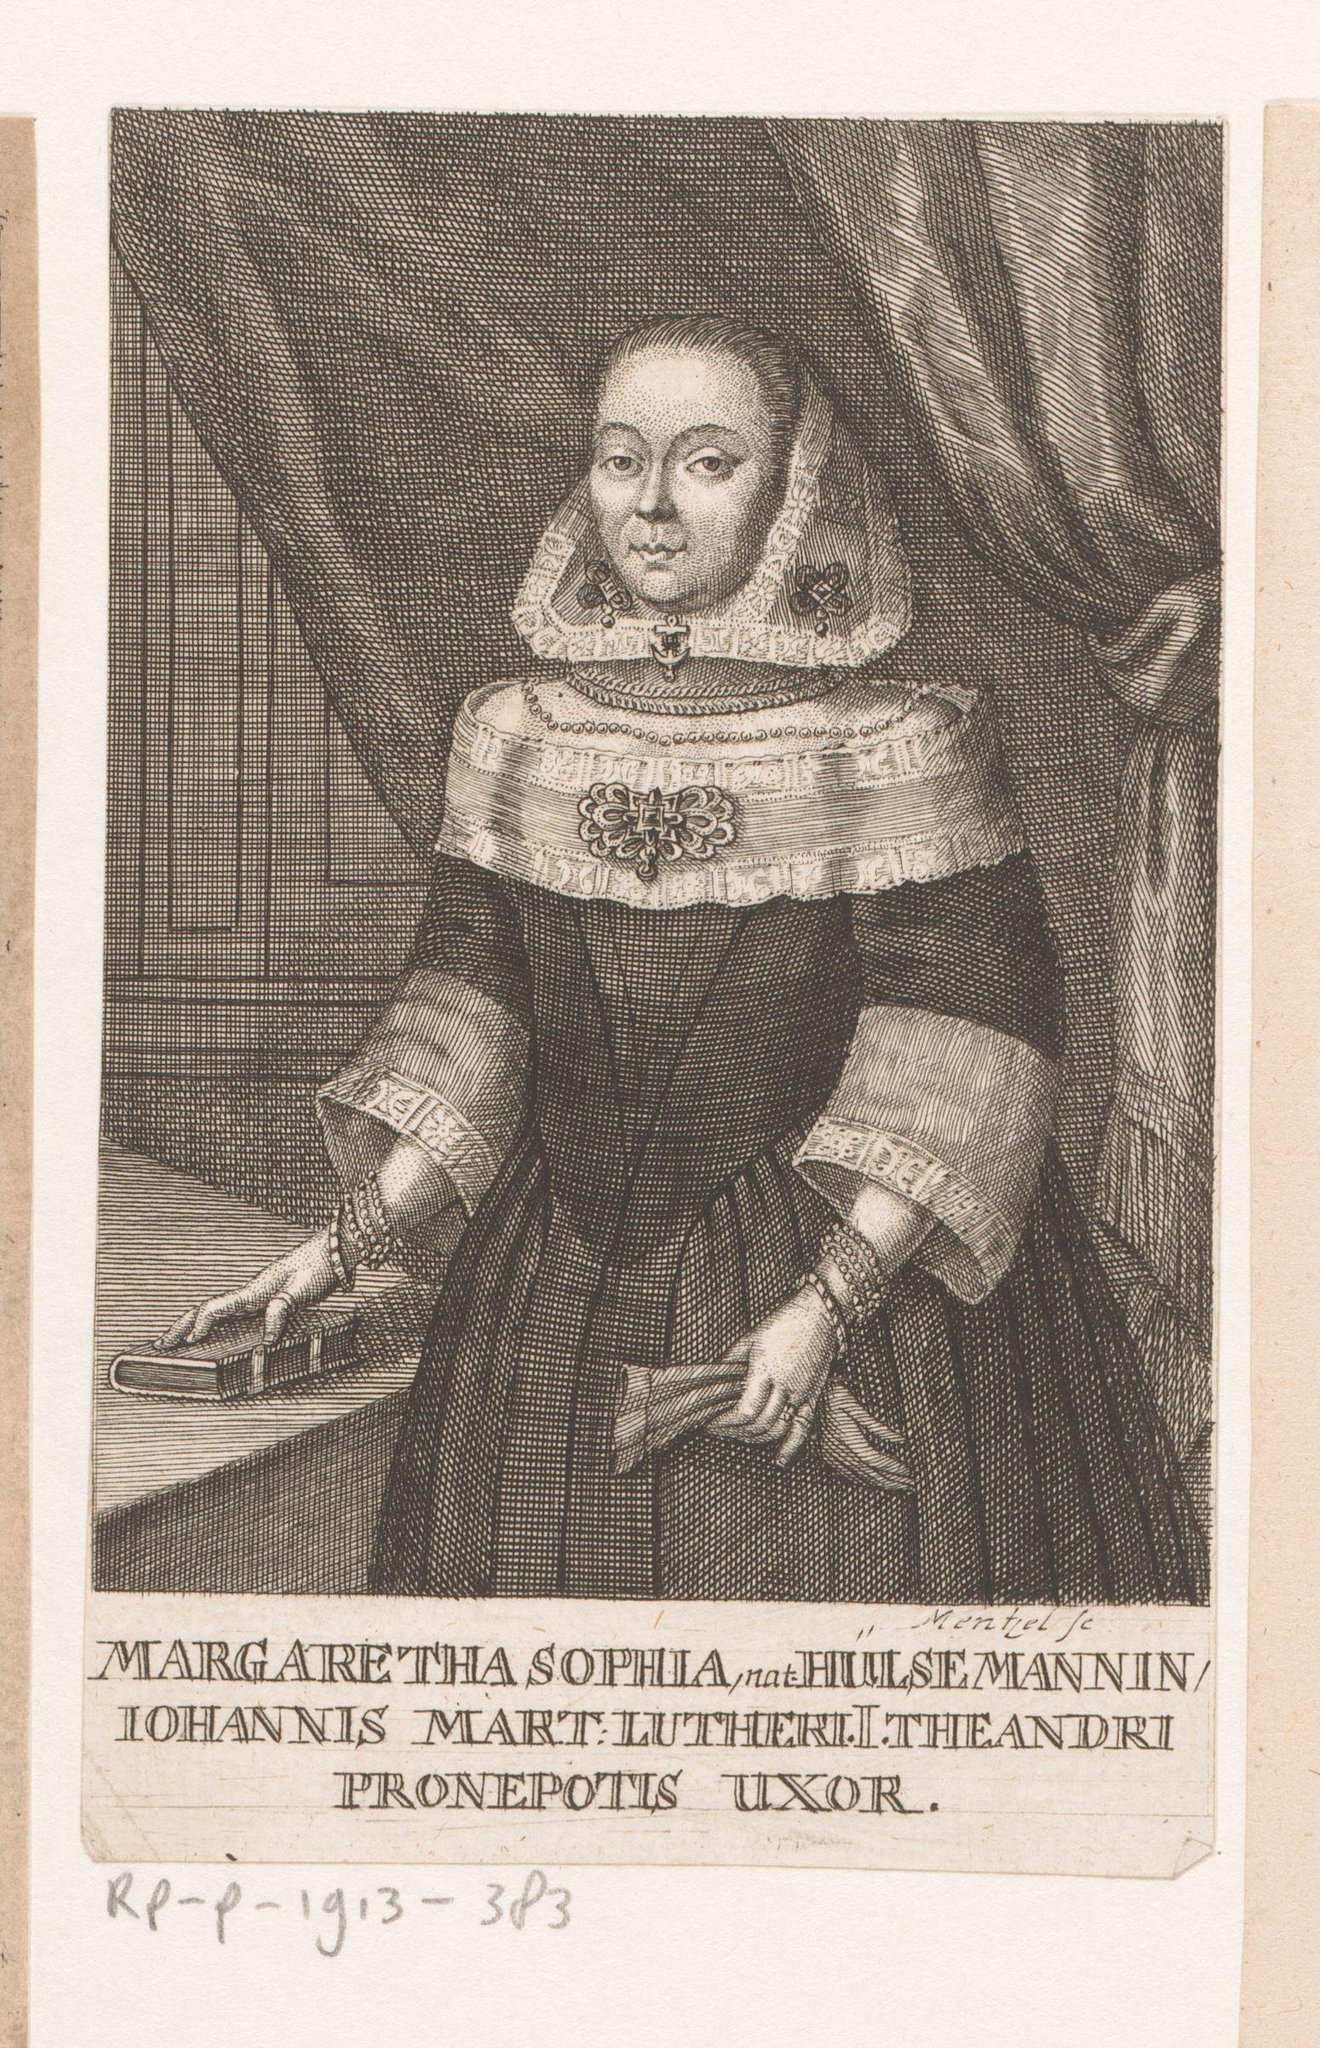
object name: print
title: Portret van Margaretha Sophia Luther-Hülsemann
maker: johann georg mentzel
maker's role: print maker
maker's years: 1677-1743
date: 1733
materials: paper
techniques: engraving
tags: historical persons - bb - woman, gloves, mittens, etc., book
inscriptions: collector's mark: Lugt 2228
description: Prent ook gebruikt in: Richter, David. Genealogia Lutherorum (...). Berlin/Leipzig: Johann Andreas Rüdiger, 1733.